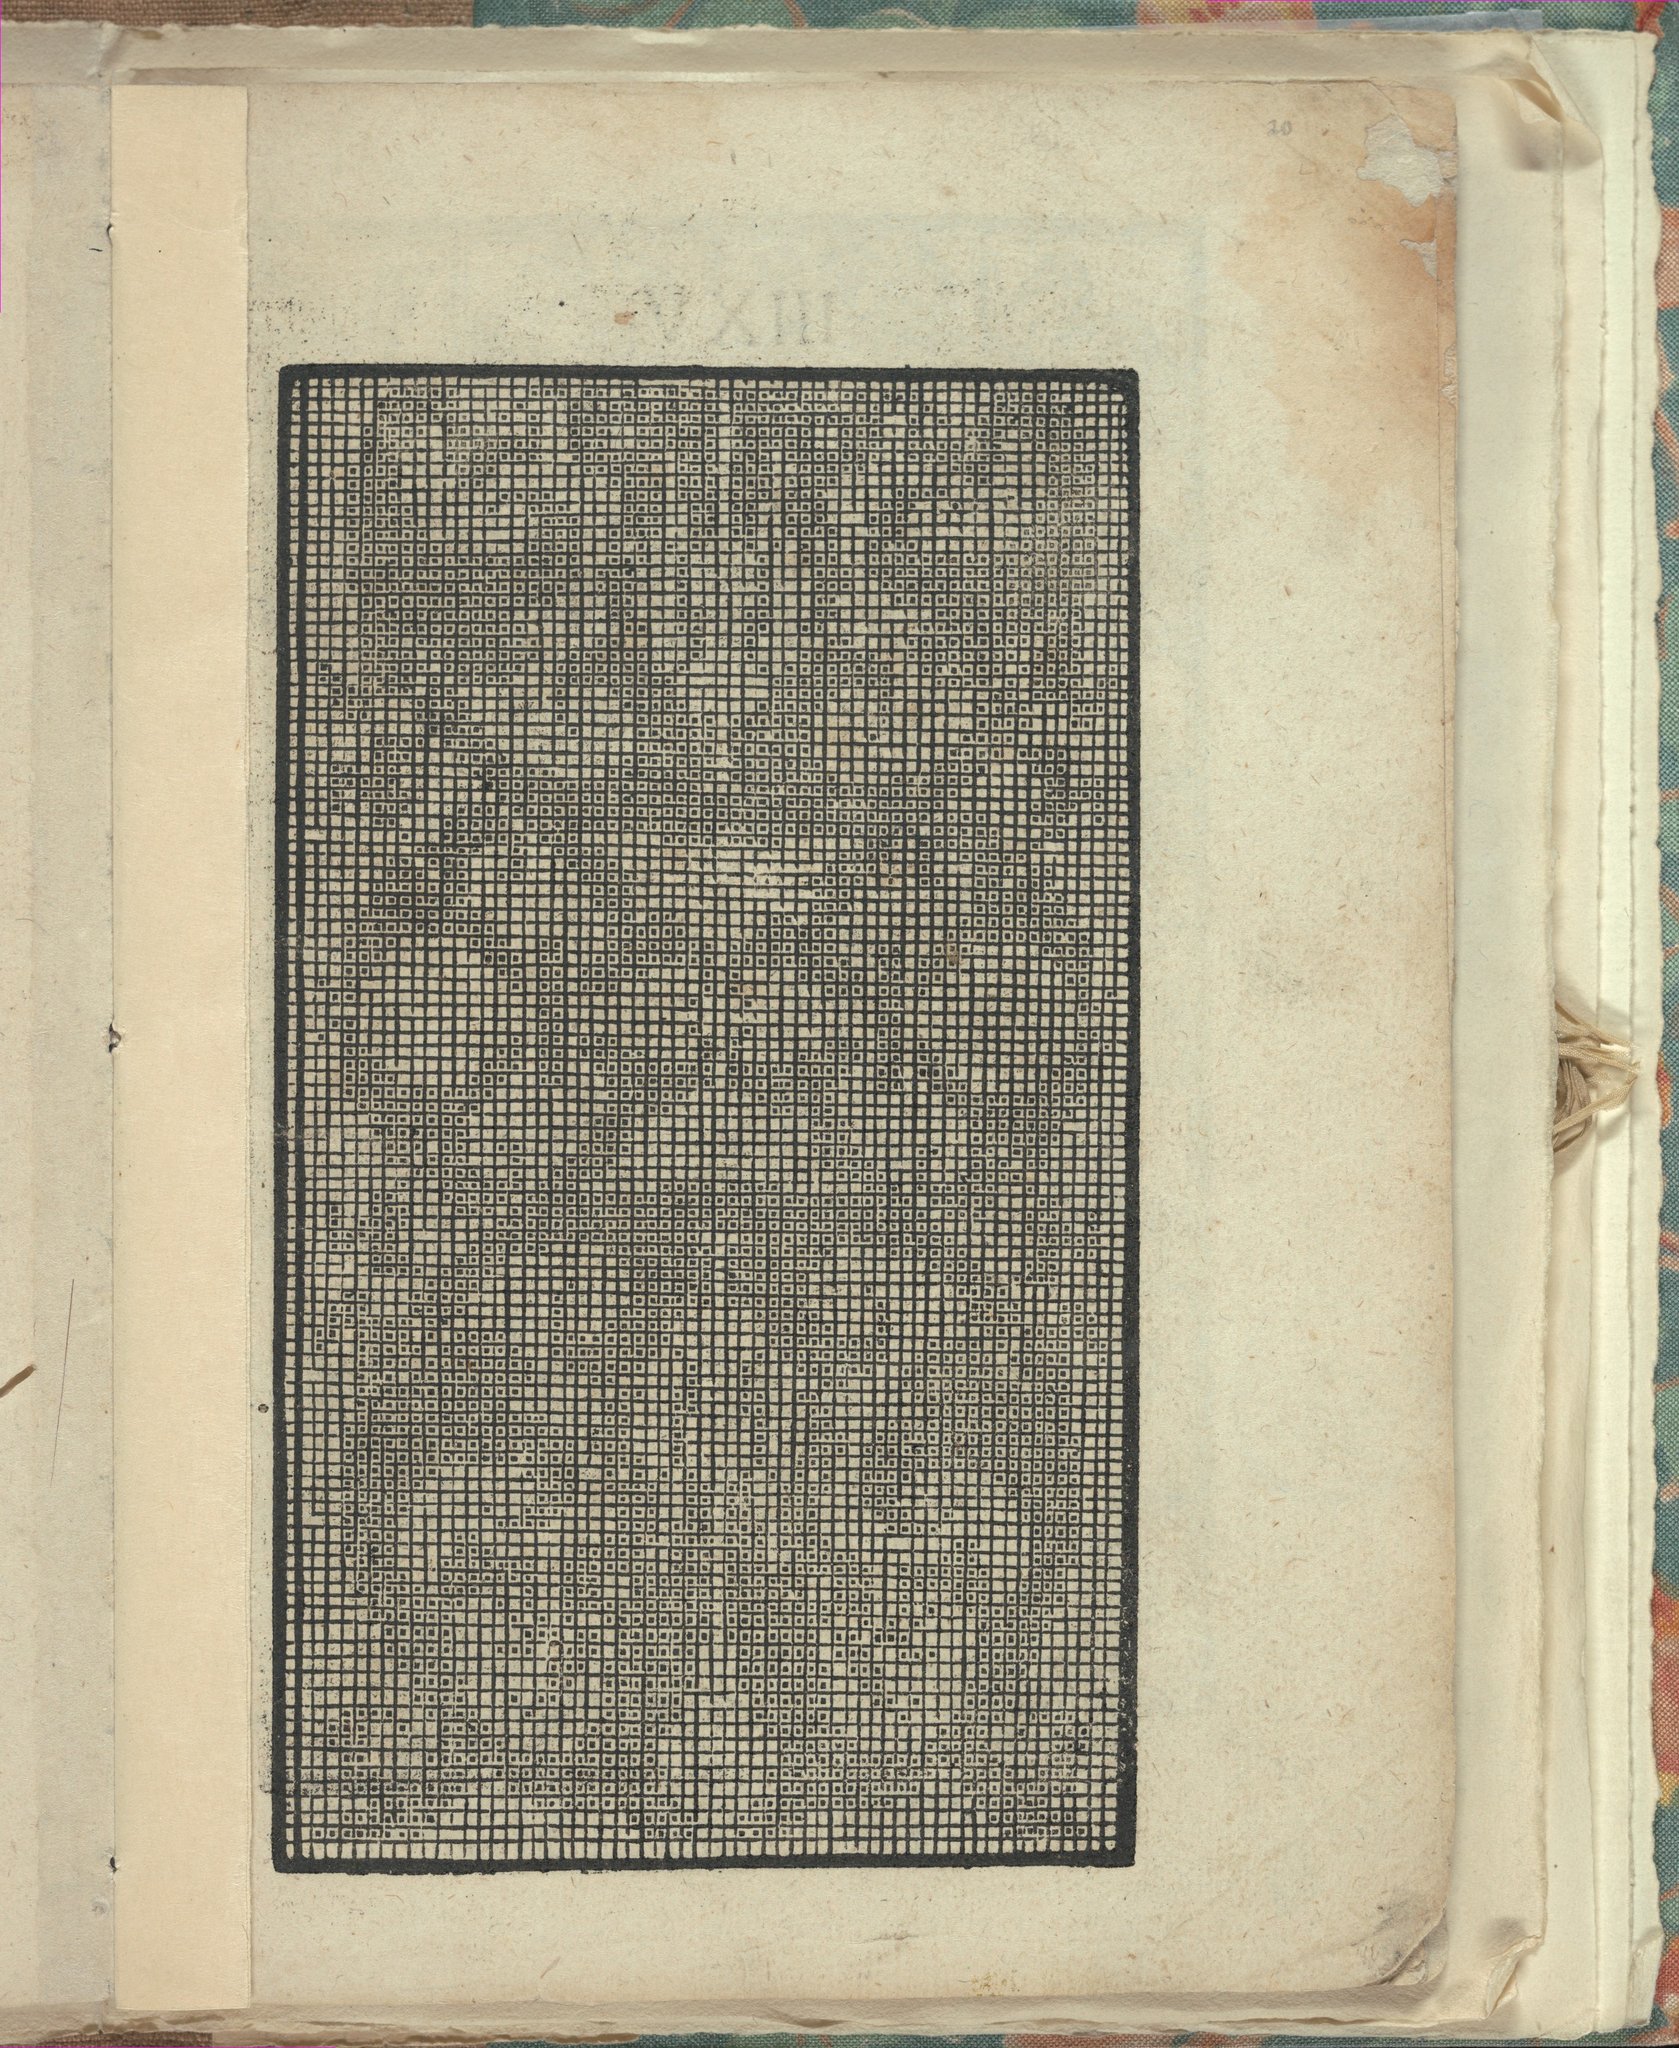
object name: book print ornament architecture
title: Opera Nova Universali intitulata Corona di racammi, page 20 (recto)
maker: giovanni andrea vavassore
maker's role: publisher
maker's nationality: italian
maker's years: 1530-1573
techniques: woodcut